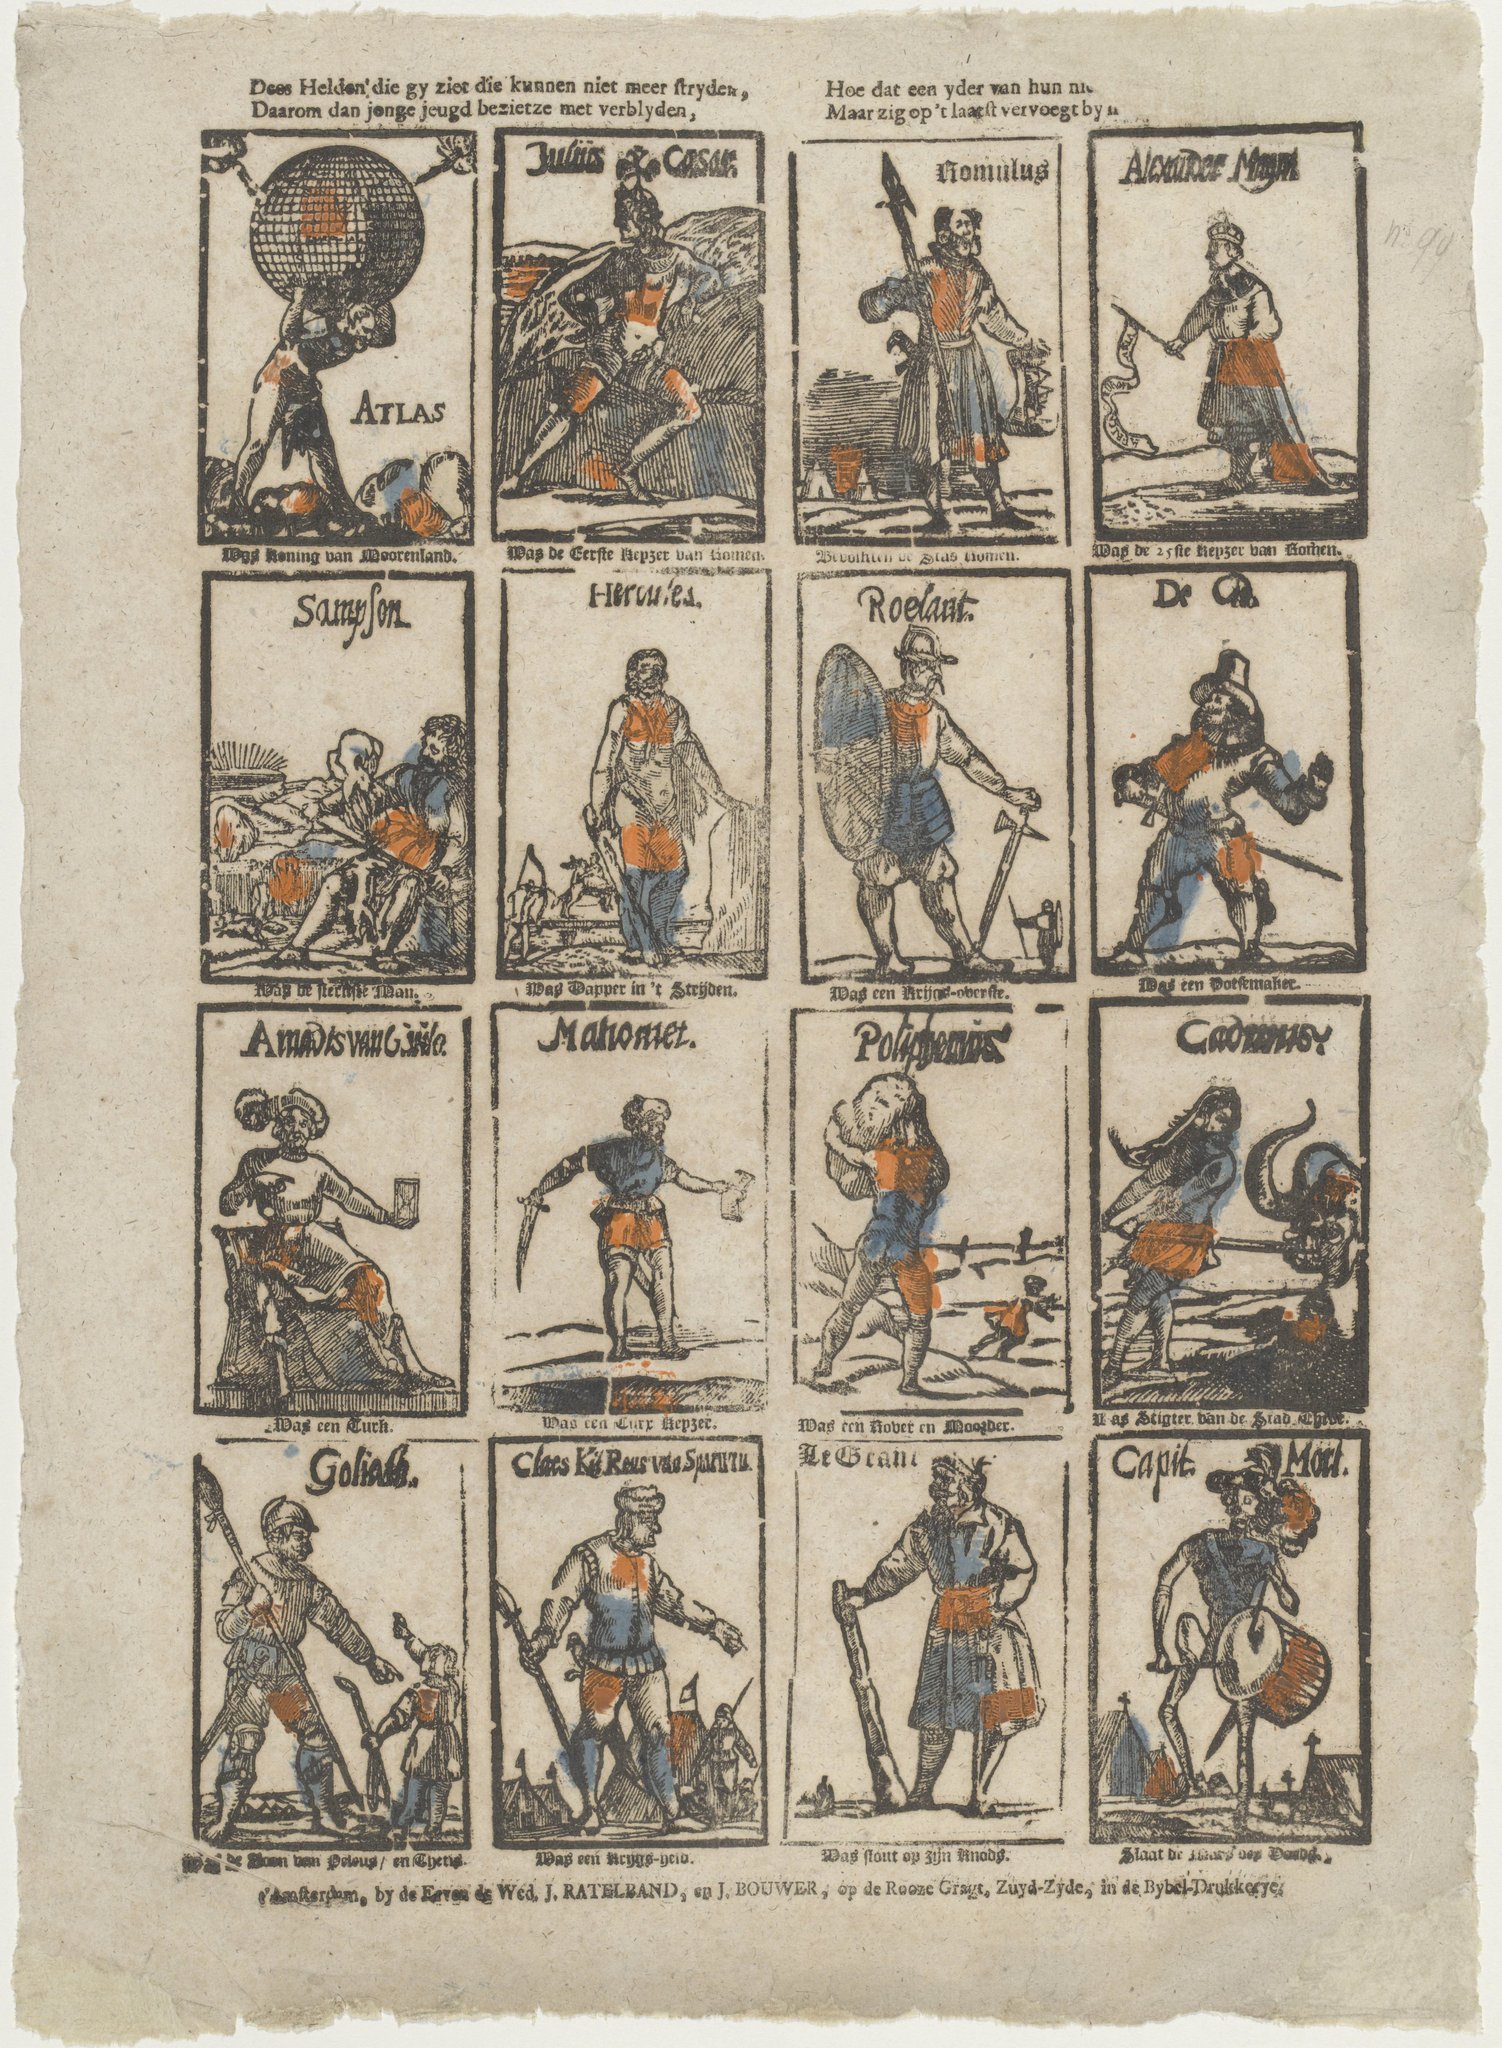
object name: print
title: Dees helden 'die gy ziet die kunnen niet meer stryden, / Daarom dan jonge jeugd bezietze met verblyden, / Hoe dan een yder van hun ni[et meer vegt en knort.] / Maar zig op 't laatst vervoegt by [hunnen Capteyn Mort]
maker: Anonymous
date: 1782-1793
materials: paper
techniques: colour, letterpress printing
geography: netherlands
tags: rome, (story of) hercules (heracles), (story of) atlas, roland, historical persons, (story of) romulus and remus, gods ~ classical mythology, samson (not in biblical context); possible attributes: broken pillar, club, jawbone, lion's head, lion's pelt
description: Blad met 16 voorstellingen van historische en mythologische figuren. Onder elke afbeelding een onderschrift in boekdruk, in elke afbeelding de naam van de figuur in houtsnede. Genummerd rechtsboven: 99.